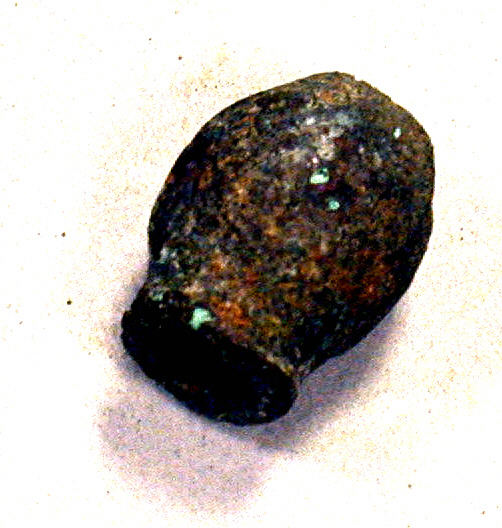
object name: vessel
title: Miniature Vessel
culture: middle niger civilization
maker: middle niger artist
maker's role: artist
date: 1101-1600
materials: copper alloy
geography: mali